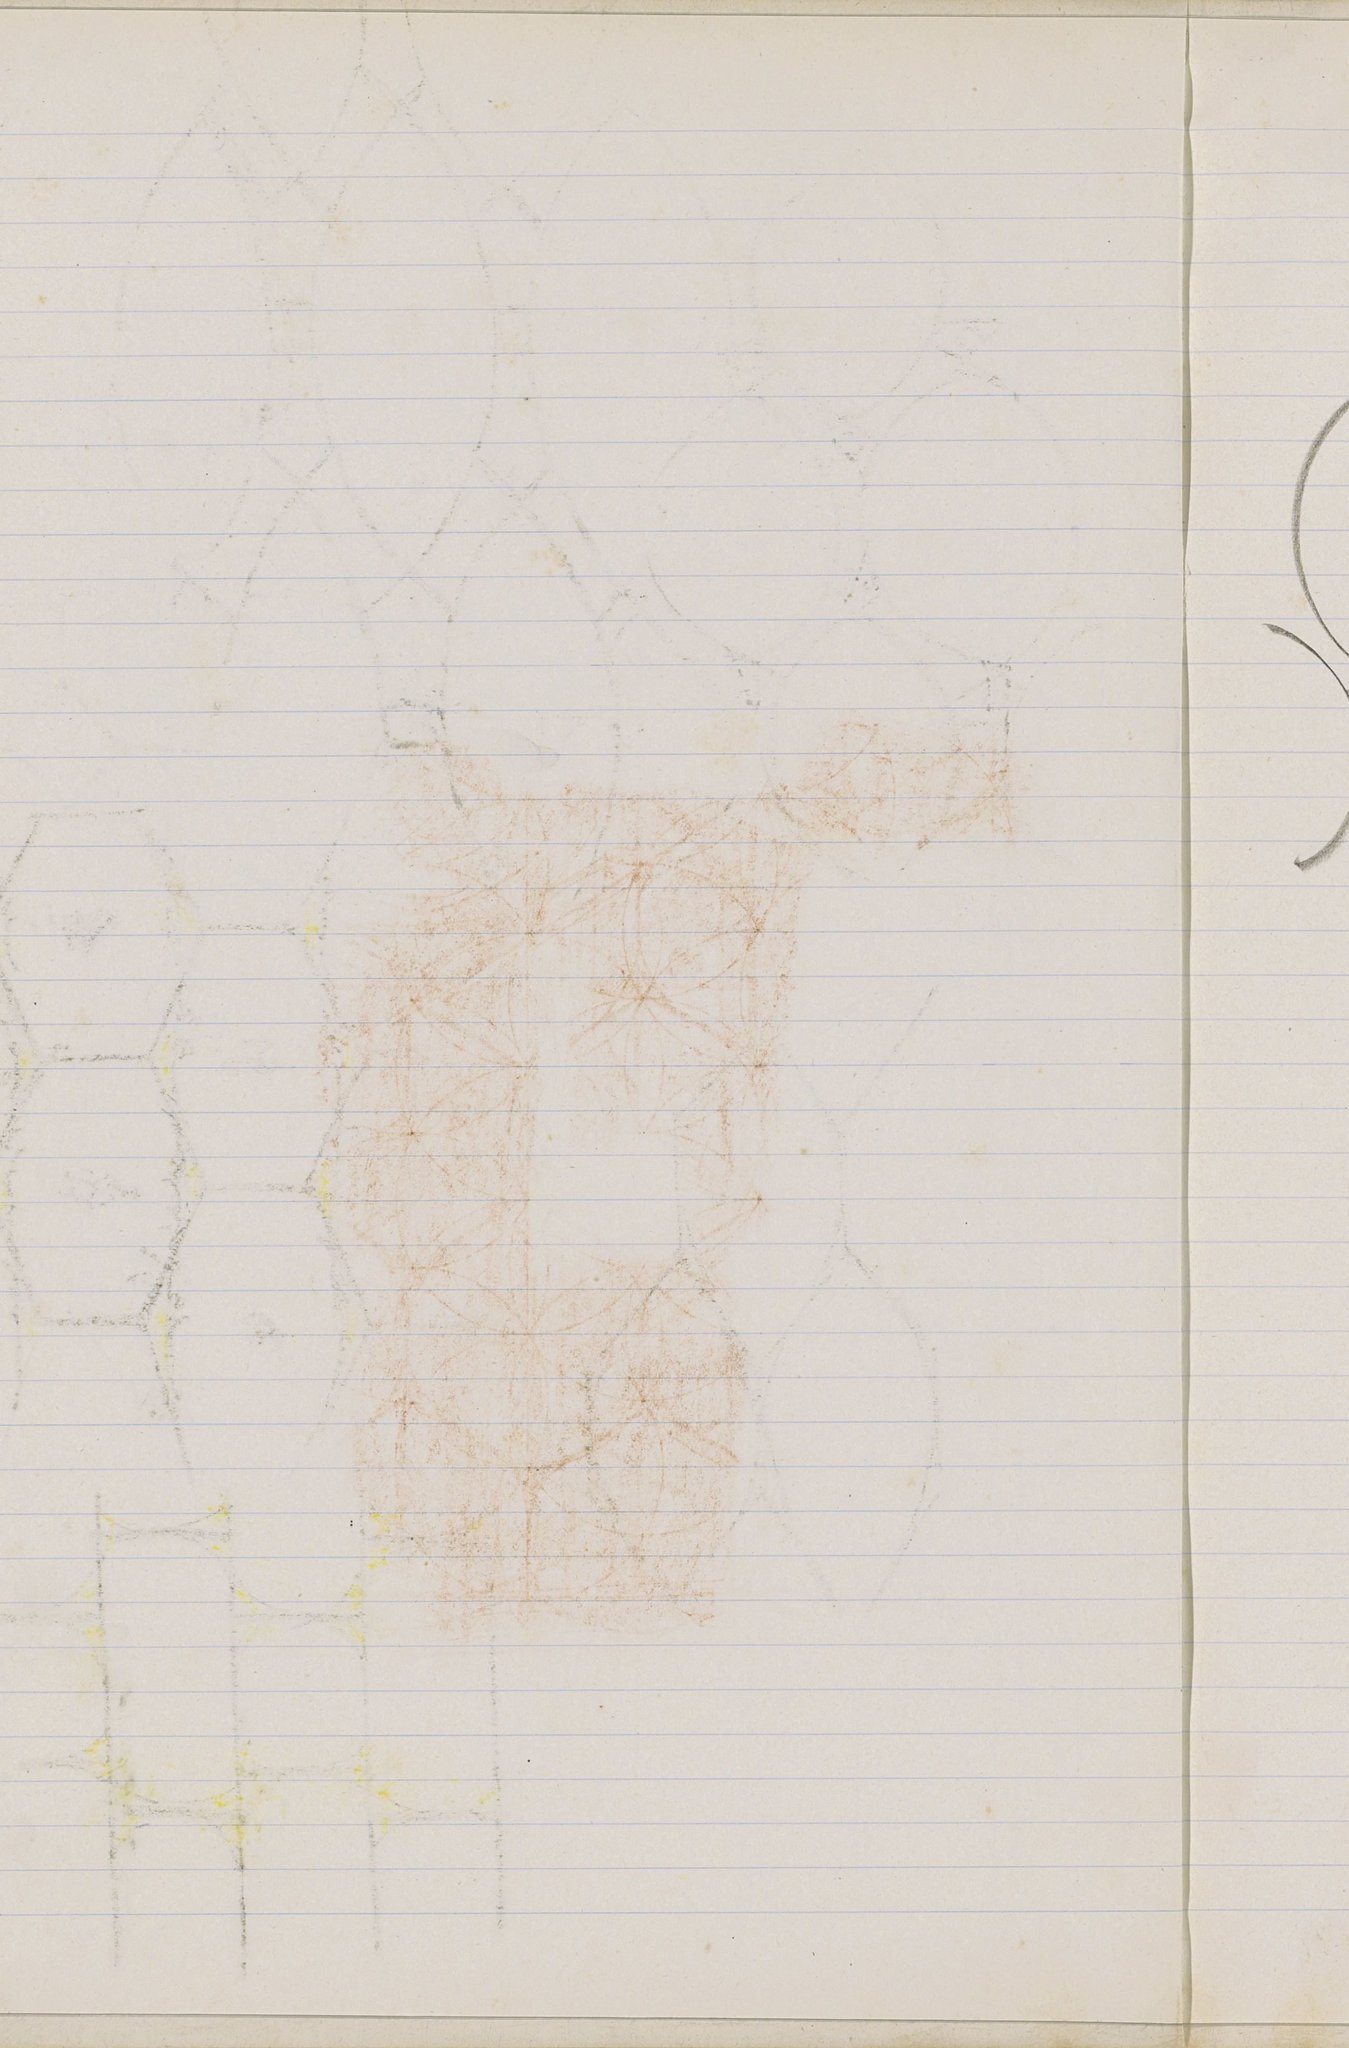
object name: sketchbook leaf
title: Abklatsch van een krijttekening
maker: gerrit willem dijsselhof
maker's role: designer, draughtsman, print maker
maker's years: 1866-1924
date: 1901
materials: lined paper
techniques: printmaking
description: Blad 33 verso uit een schetsboek met 79 bladen.